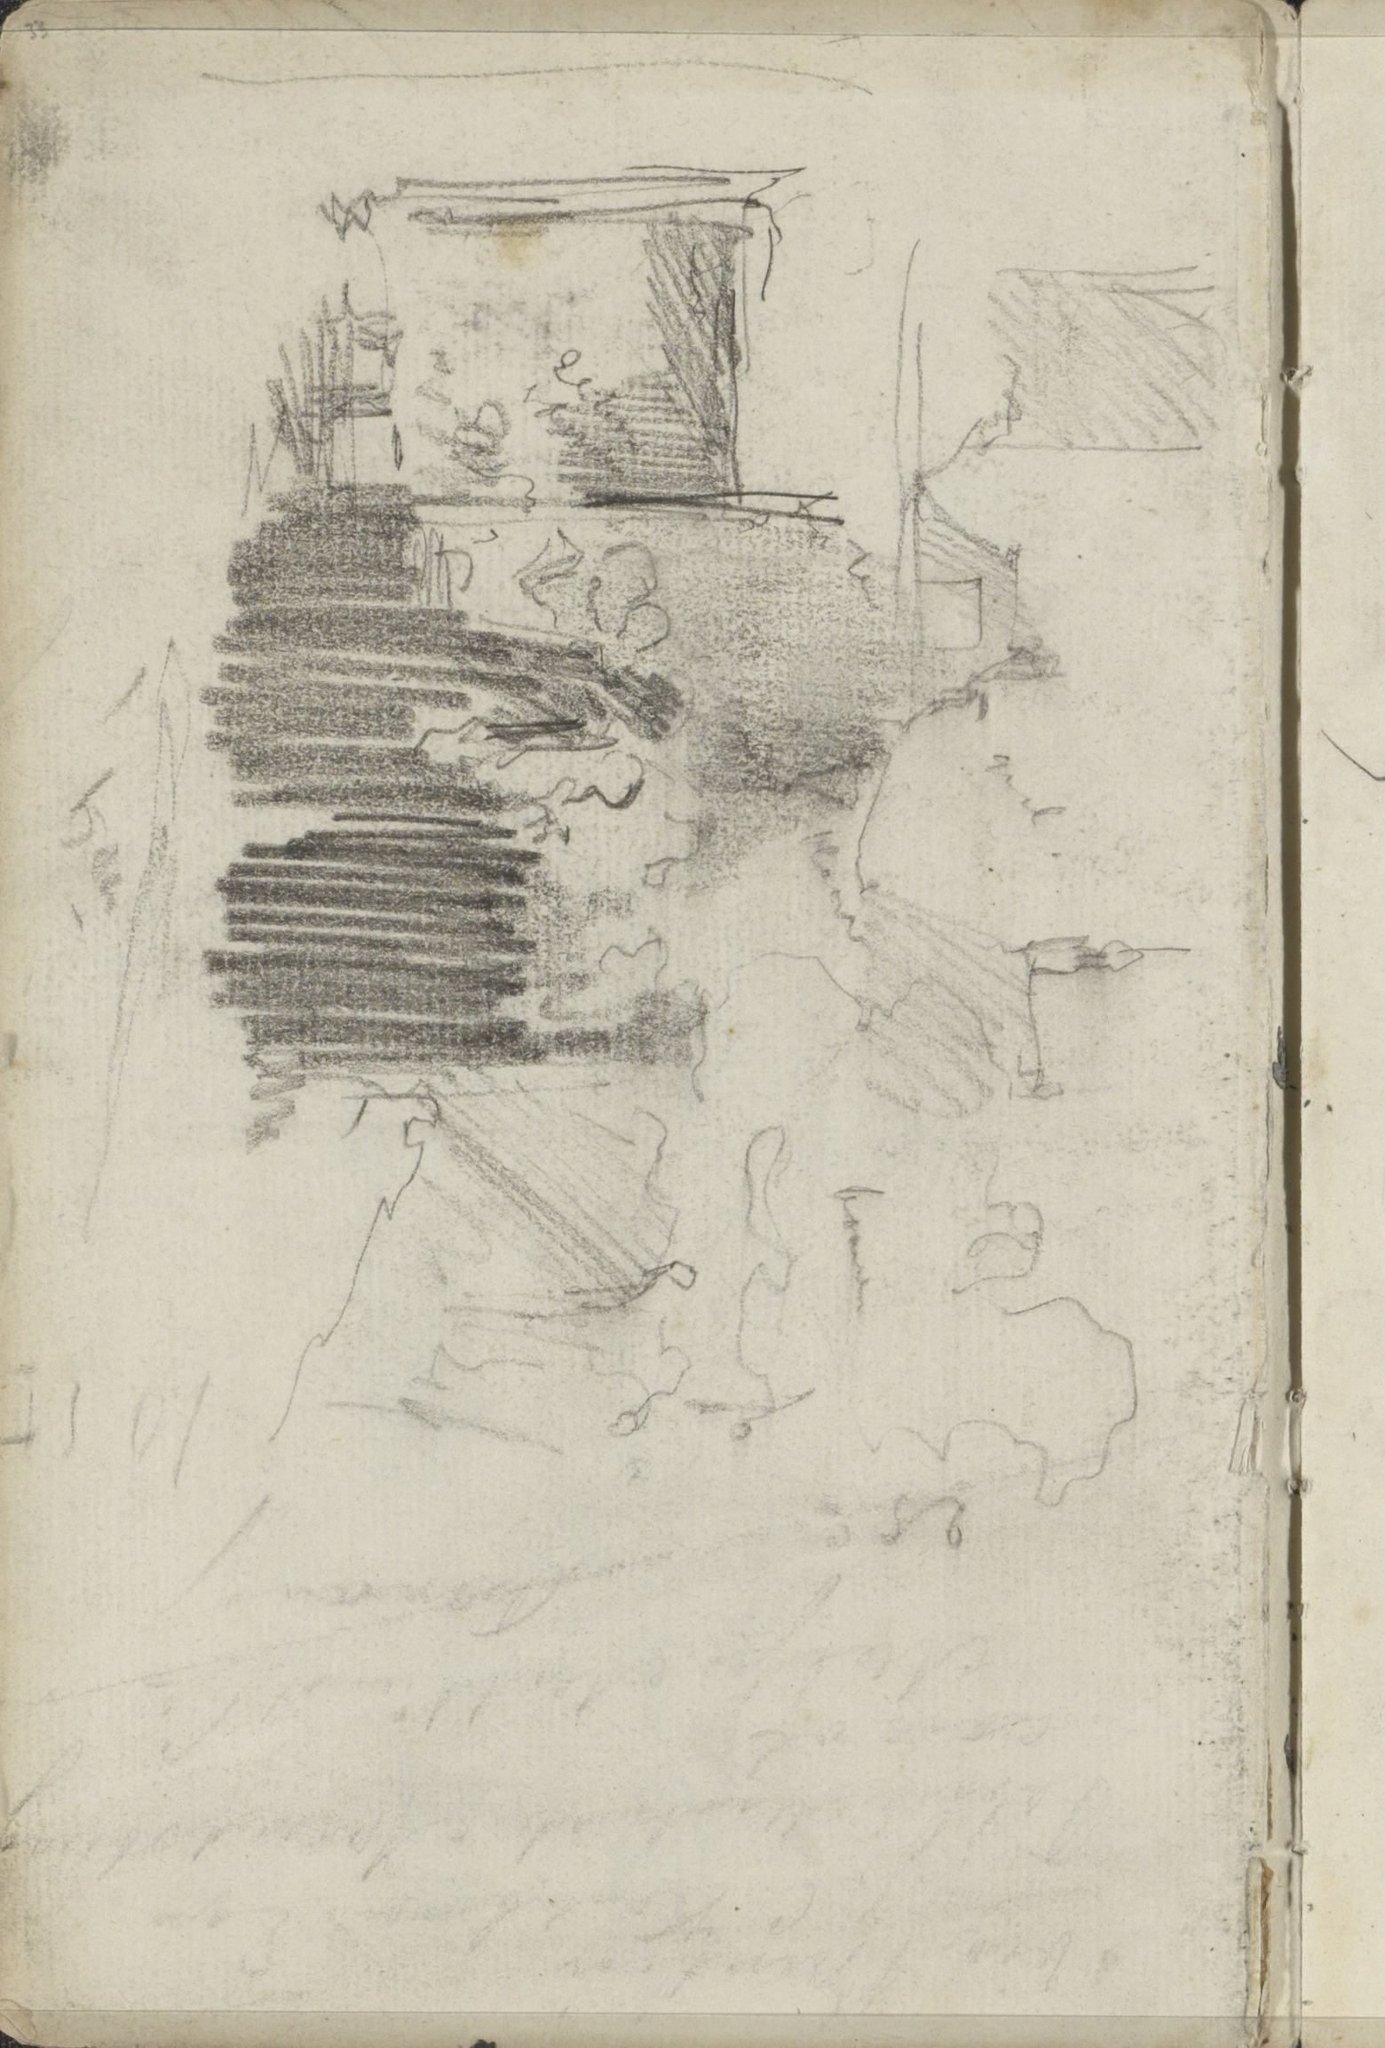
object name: sketchbook leaf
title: Figuren in een stad of dorp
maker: george hendrik breitner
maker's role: draughtsman, painter, print maker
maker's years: 1857-1923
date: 1880-1882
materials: chalk, paper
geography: the hague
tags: village (+ city(-scape) with figures, staffage), city-view, and landscape with man-made constructions (+ city(-scape) with figures, staffage)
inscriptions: kleurnotitie, handgeschreven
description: Pagina 33 uit een schetsboek met 23 bladen.